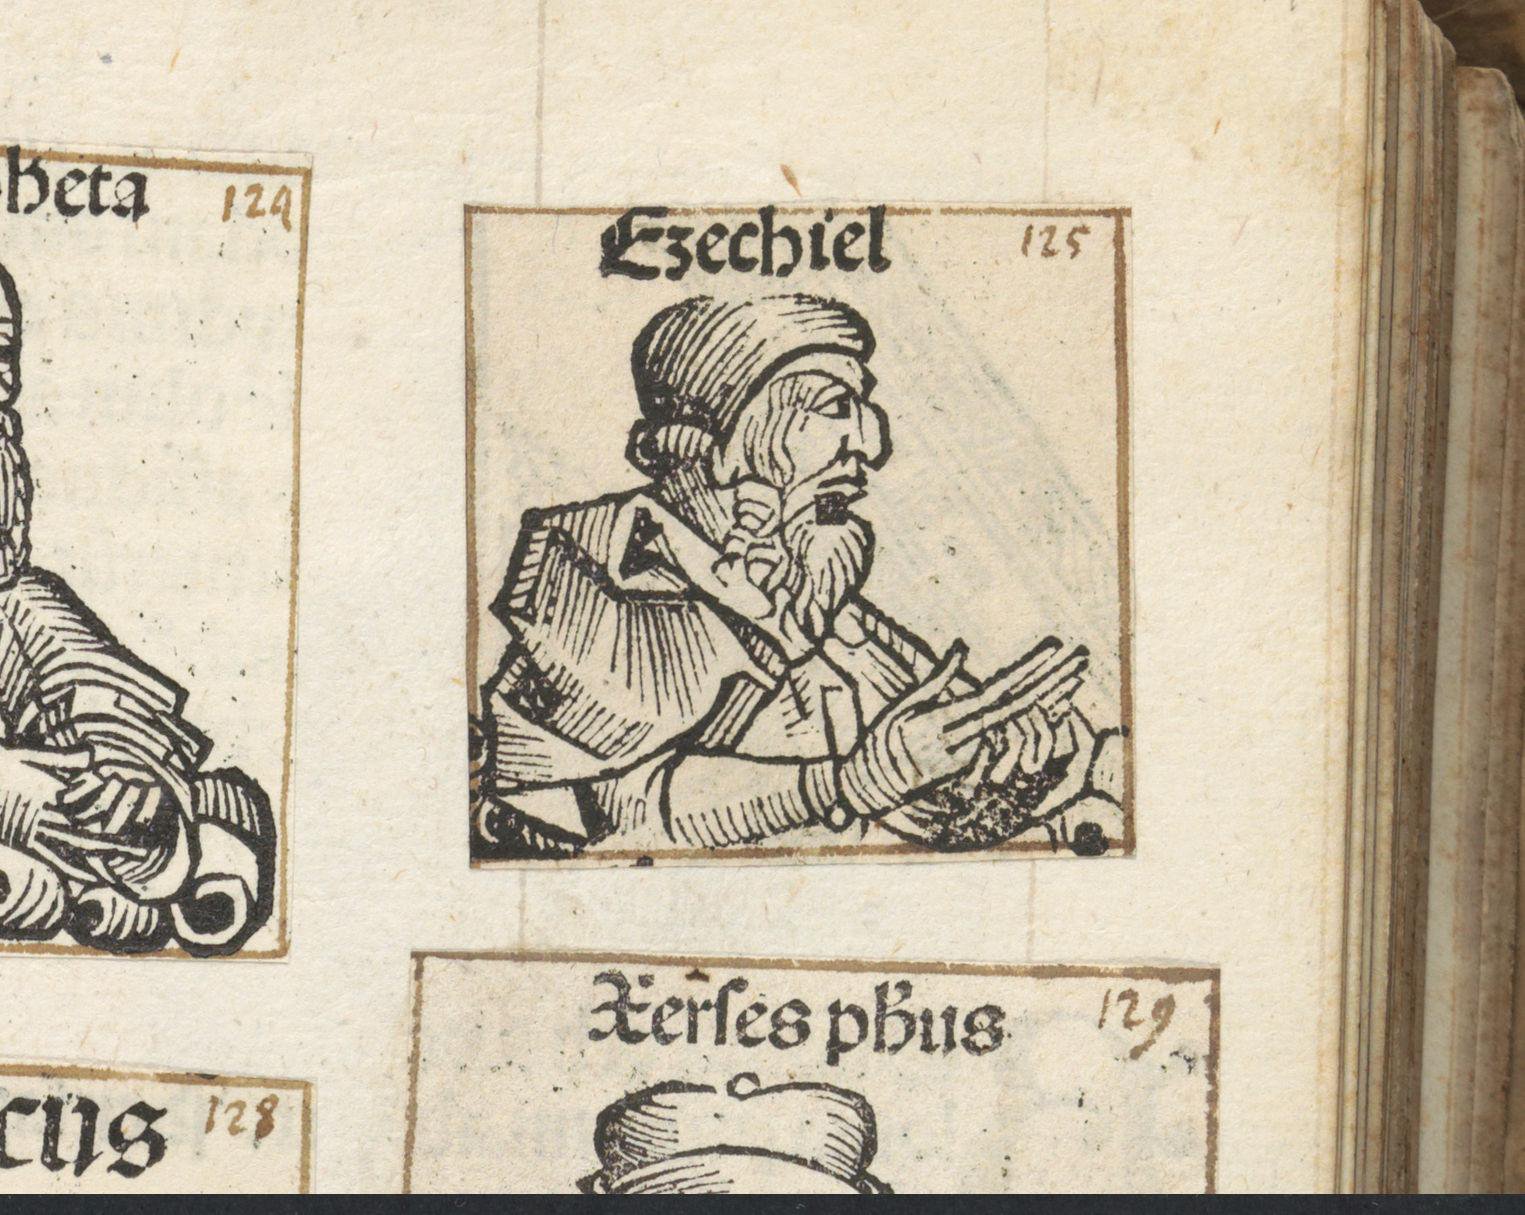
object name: book illustration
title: Ezechiel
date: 1493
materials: paper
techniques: letterpress printing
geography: nuremberg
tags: persons from the old testament (not in biblical context, nor occurring in legendary/historical extensions included in division 71)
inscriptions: inscription: ‘125’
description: De houtsnede wordt gebruikt als boekillustratie in de Liber Chronicarum (of Neurenbergkroniek) van Hartmann Schedel, verschenen in het Latijn en Duits in 1493. Zie de Latijnse uitgave, folio 65v.